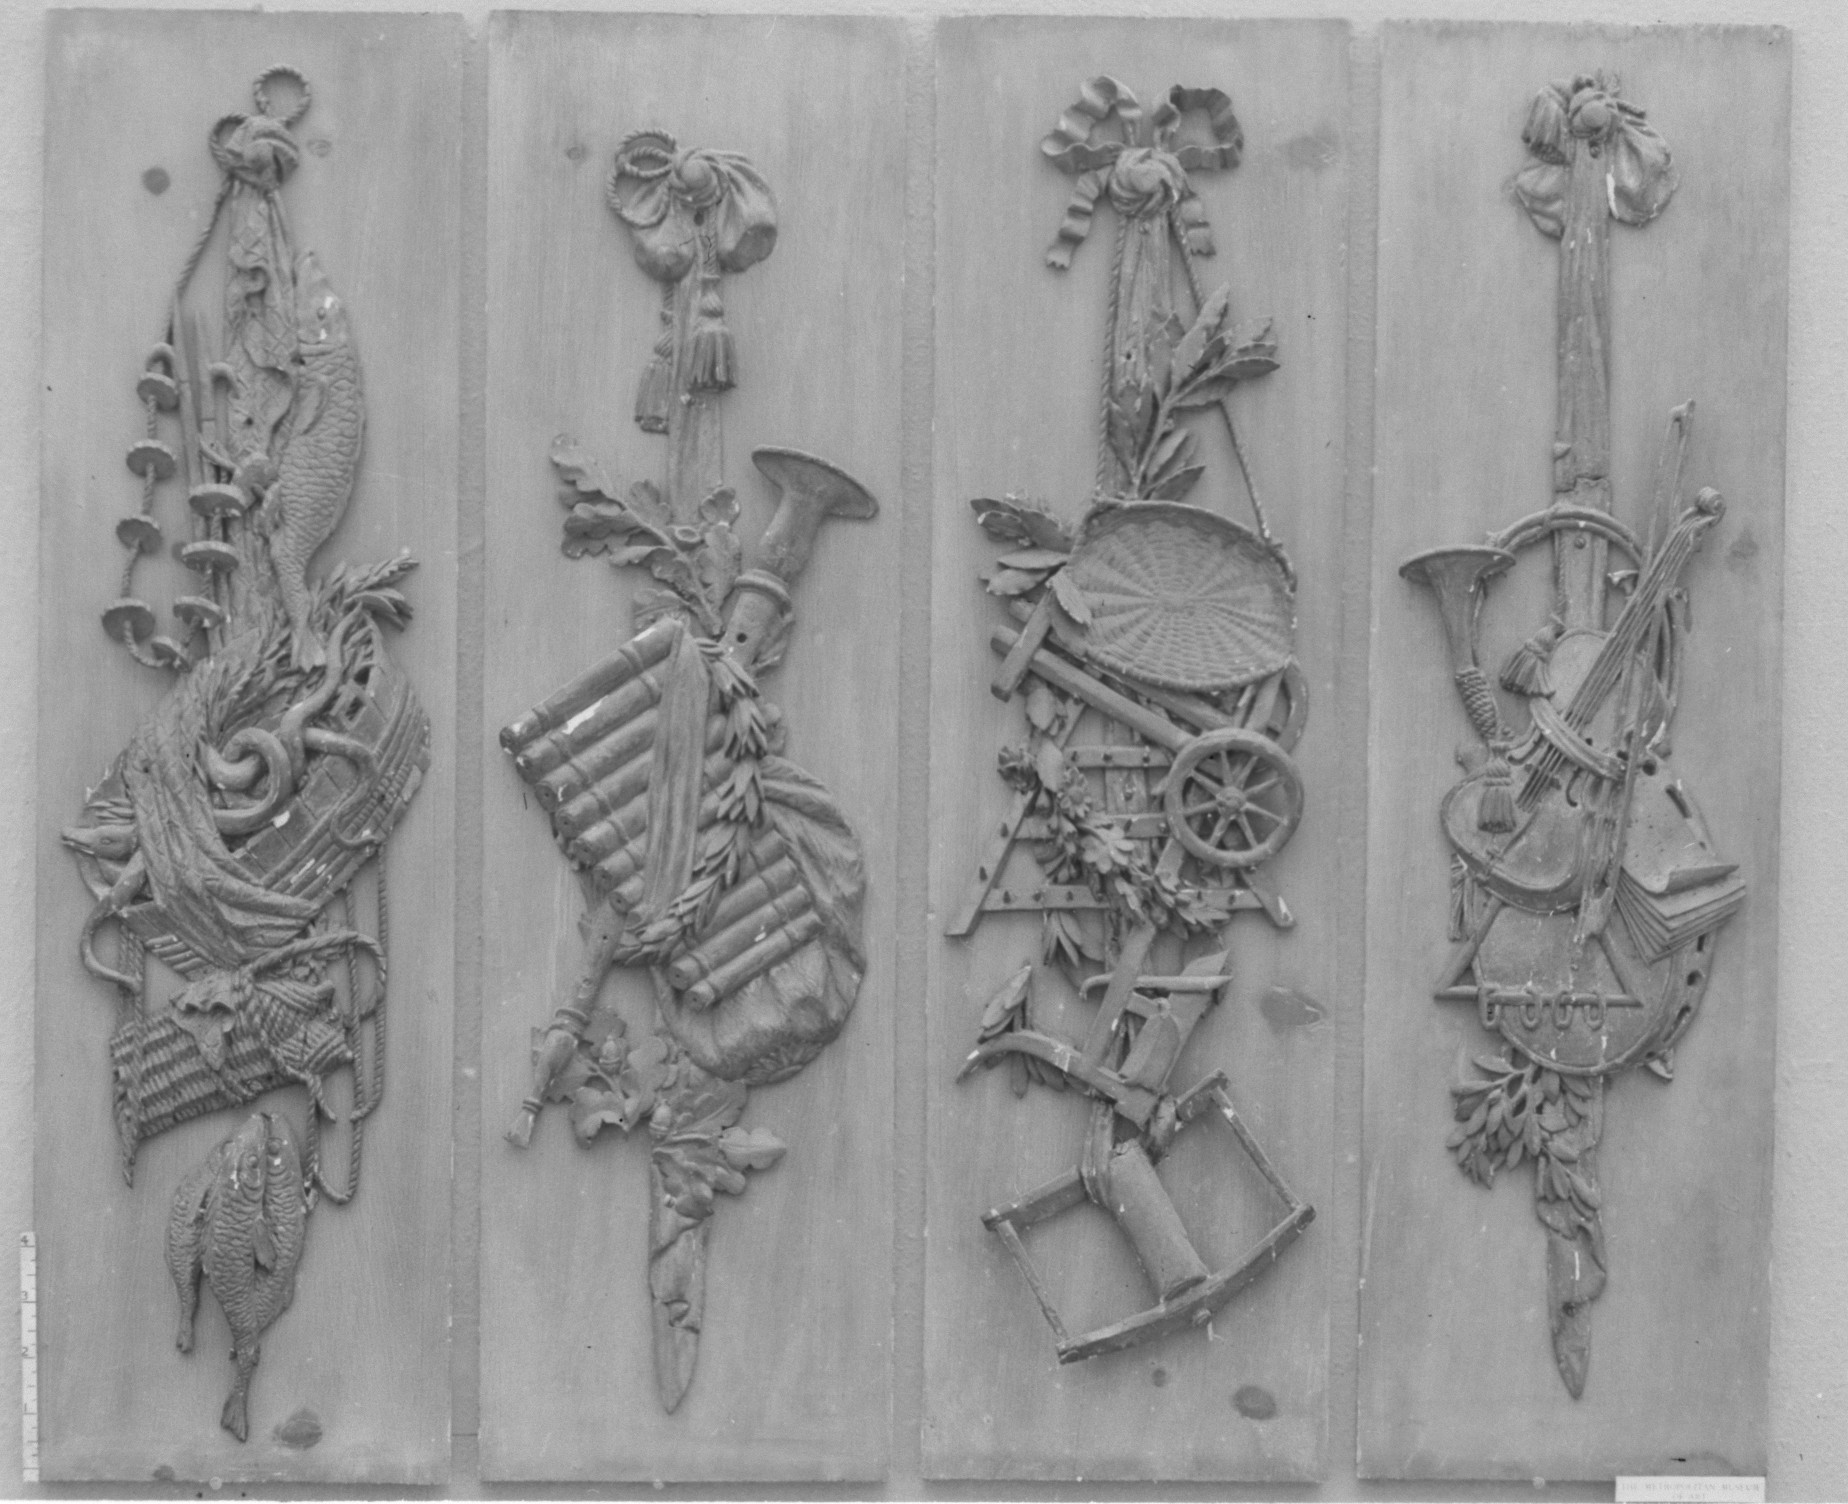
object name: panel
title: Panel (part of a set)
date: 1701-1800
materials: wood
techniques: gilding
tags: musical instruments,fish